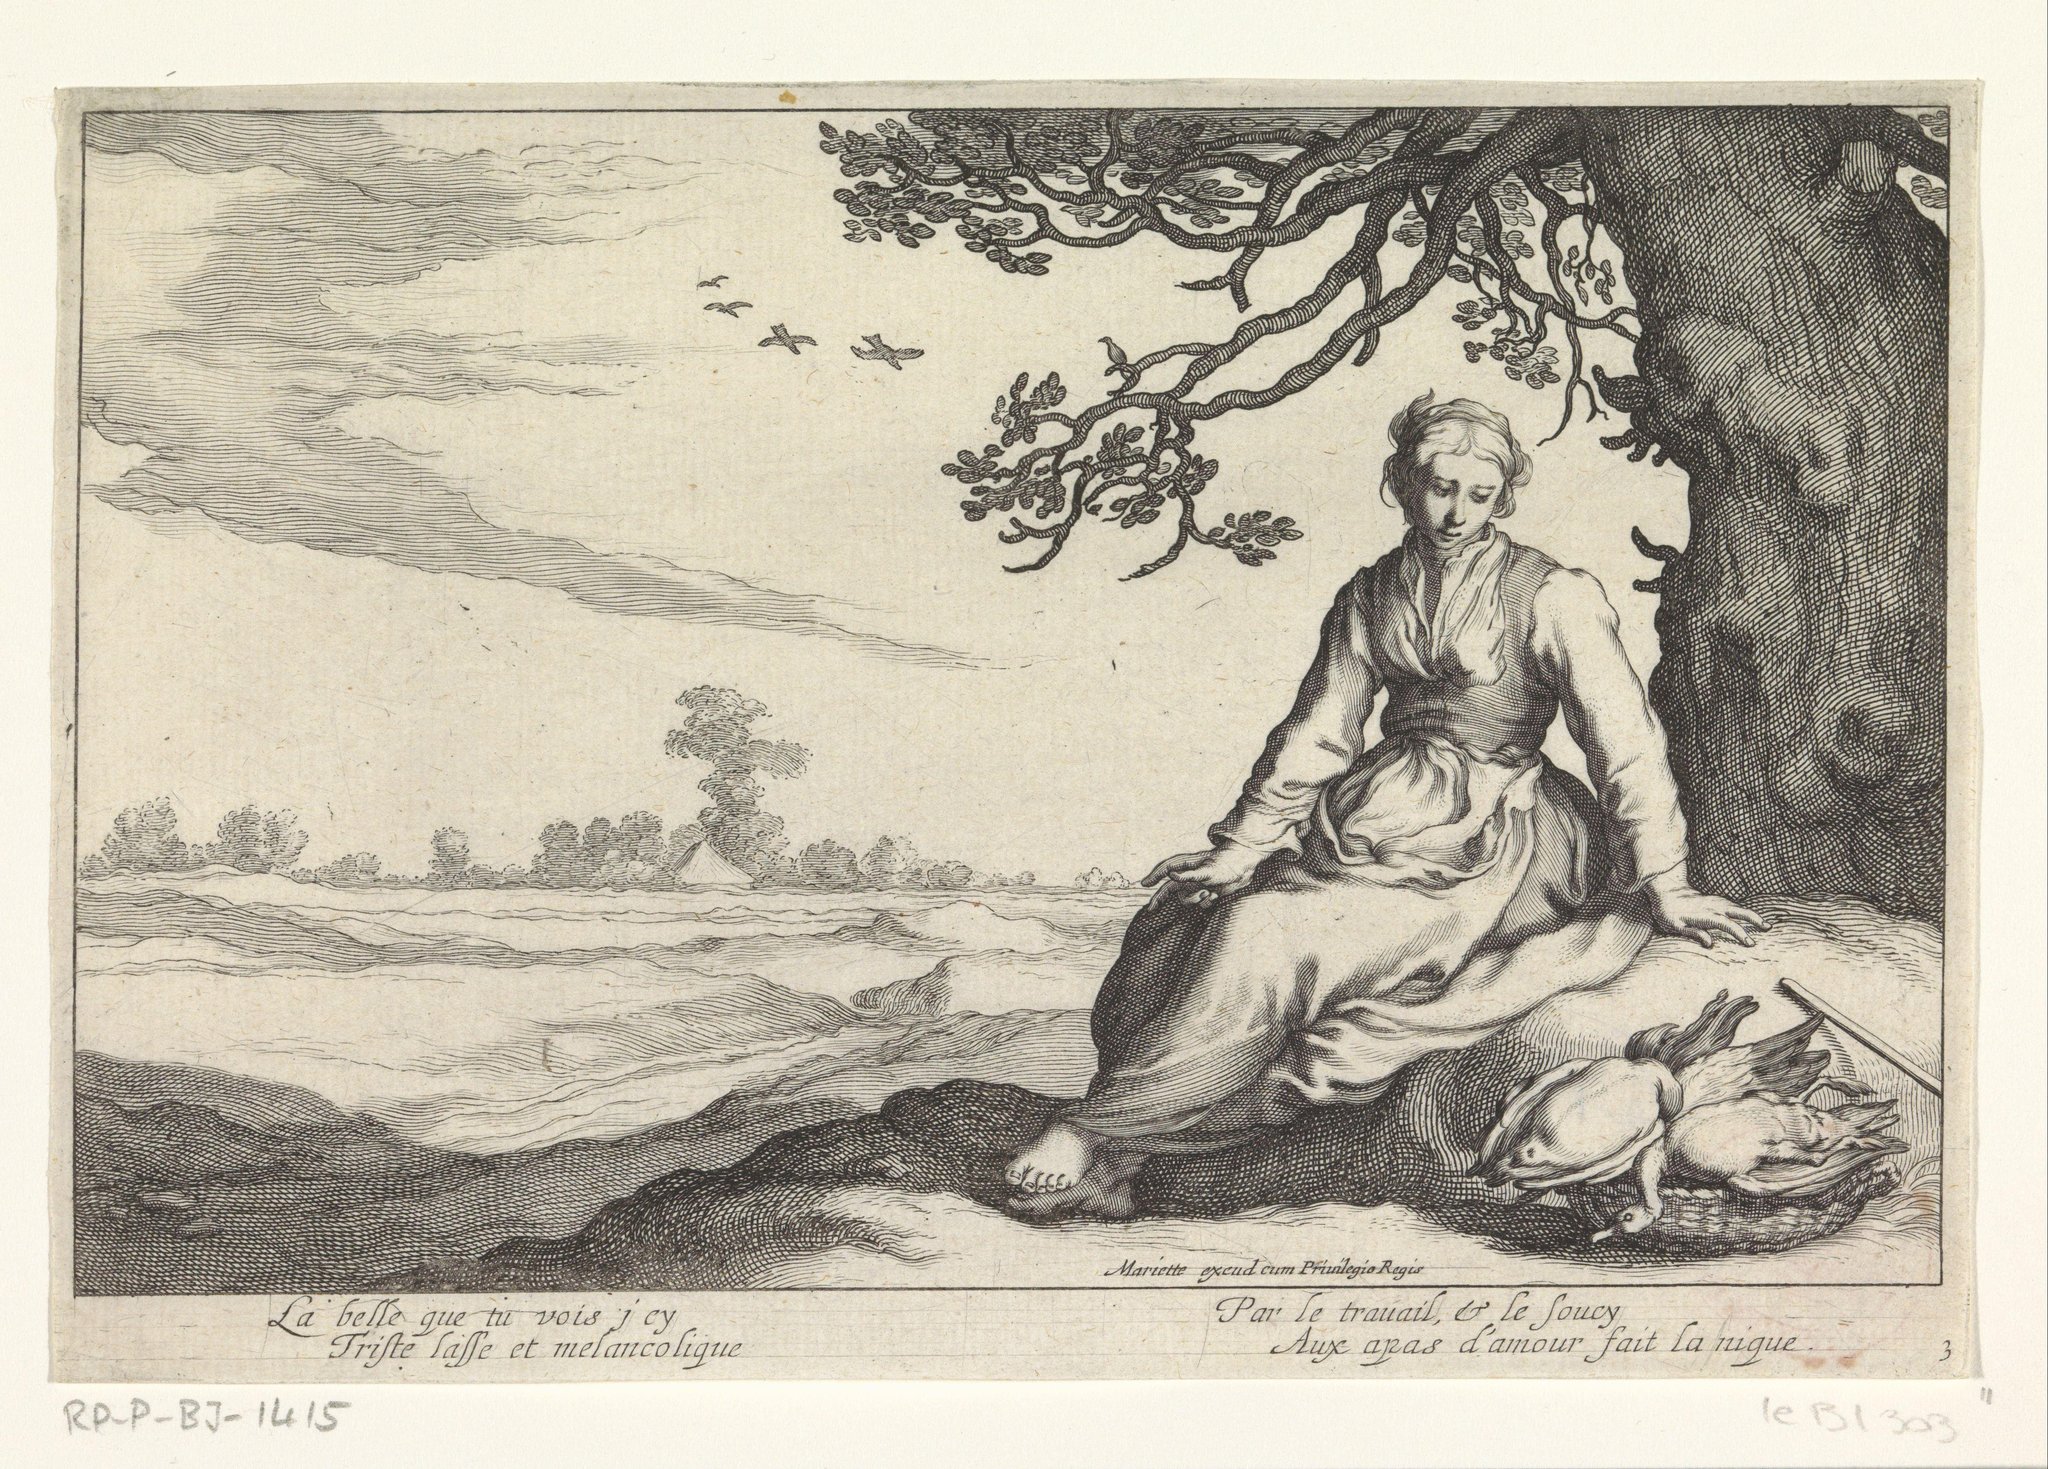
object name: print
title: Vier pastorale scènes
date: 1650-1716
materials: paper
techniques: engraving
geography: paris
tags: pastorals, arcadian scenes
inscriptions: collector's mark: Lugt 240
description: Een vrouw rust uit onder een boom in een landelijke omgeving. Naast haar twee ganzen. Met vierregelig Franstalig onderschrift.